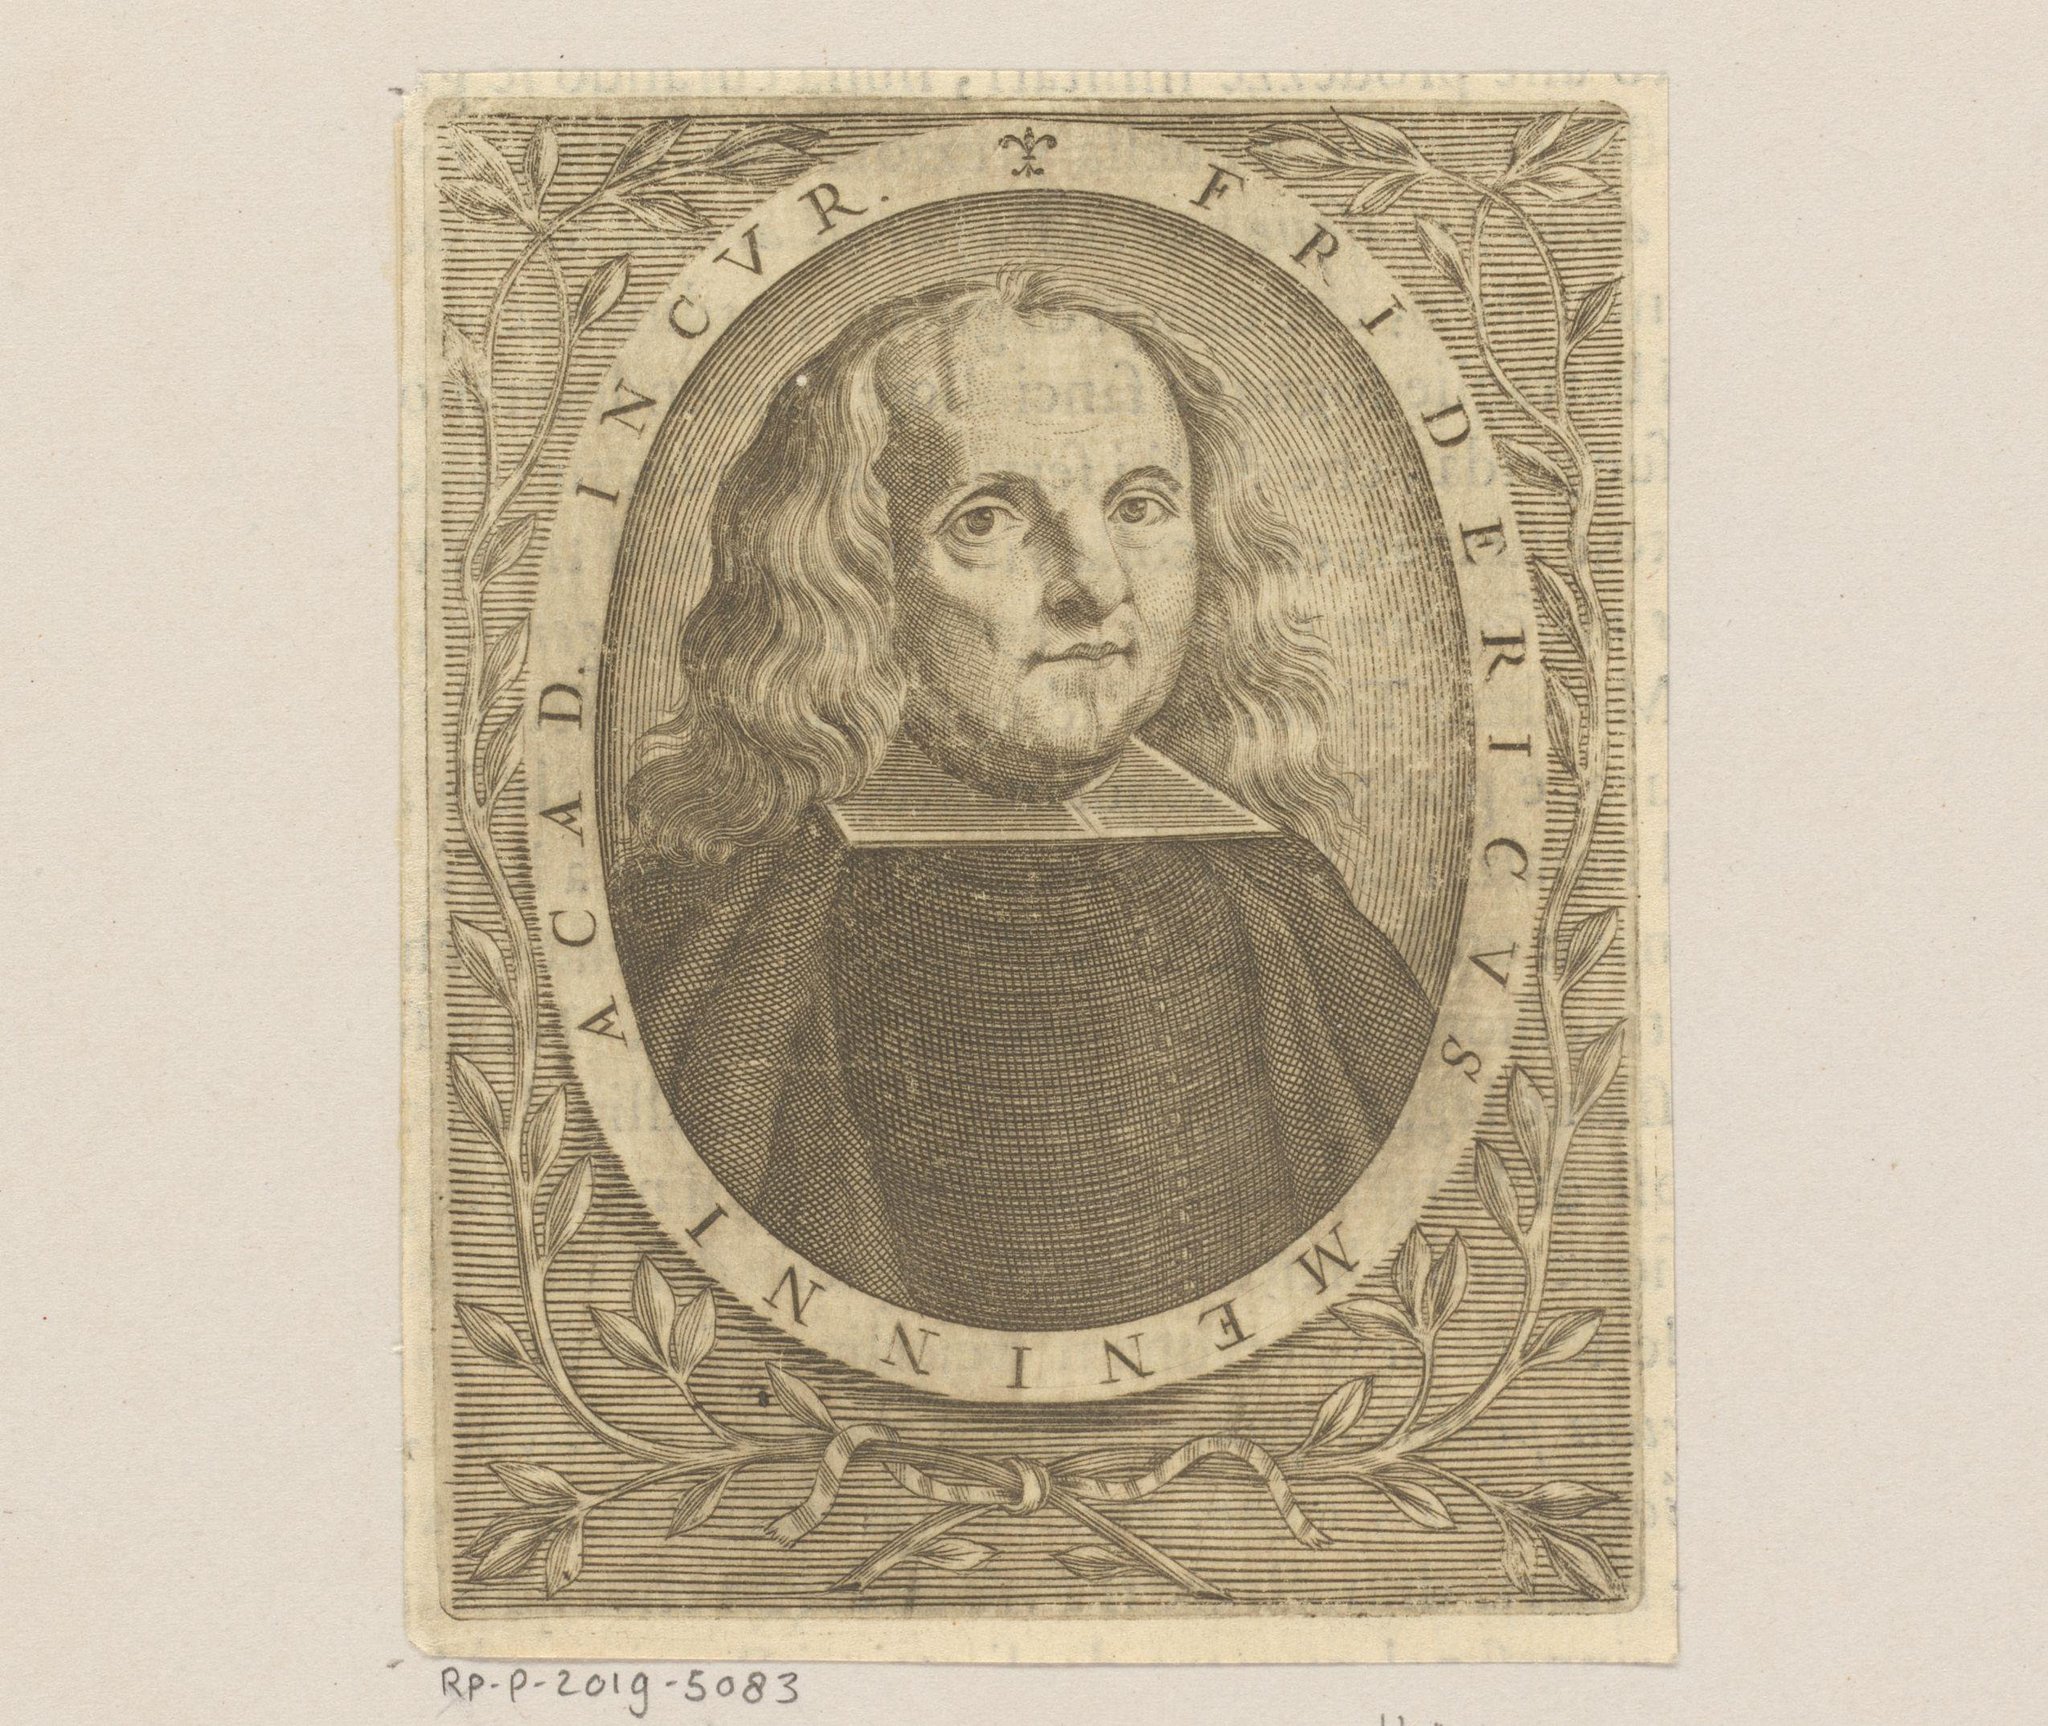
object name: print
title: Portret van Federigo Meninni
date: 1703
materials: paper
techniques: engraving, etching, letterpress printing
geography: naples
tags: naples, historical persons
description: Prent uit: Gimma, Giacinto. Elogj accademici della Società degli Spensierati di Rossano (...). Napels: Carlo Troise, 1703, p. 121.